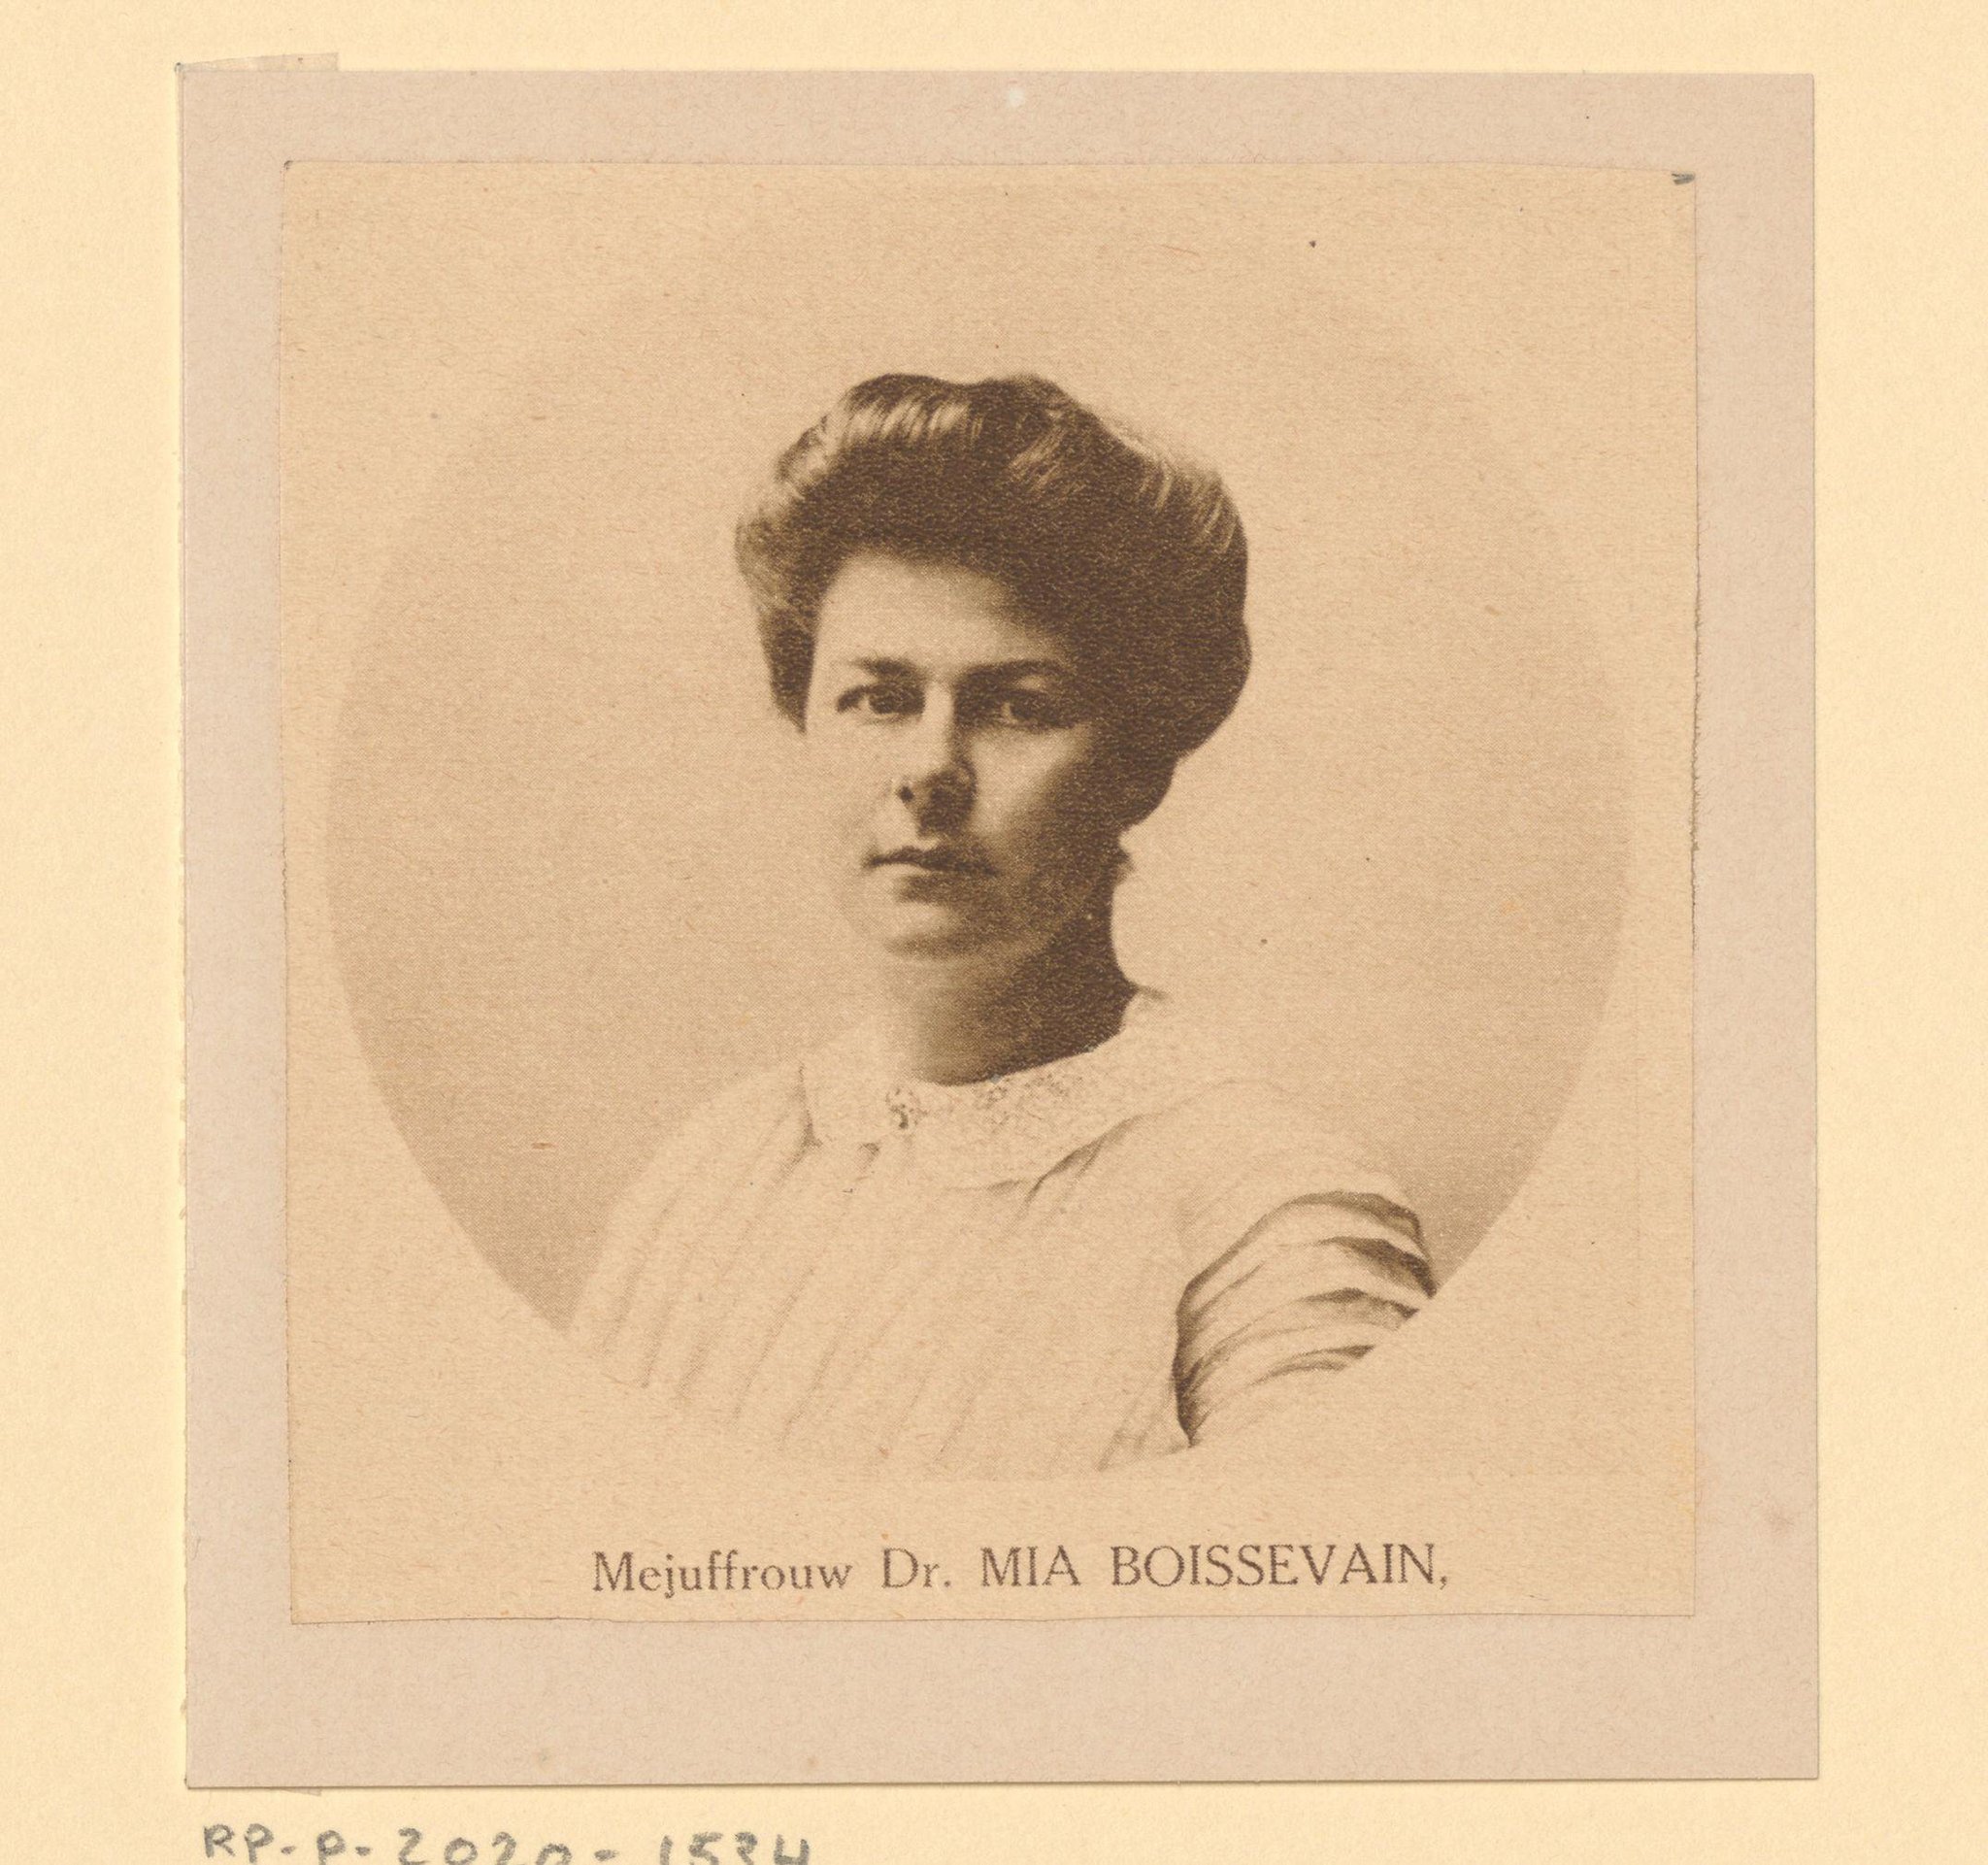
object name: photomechanical print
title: Portret van Mia Boissevain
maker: Anonymous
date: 1903-1915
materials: paper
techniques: rotogravure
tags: amsterdam, london, historical persons - bb - woman